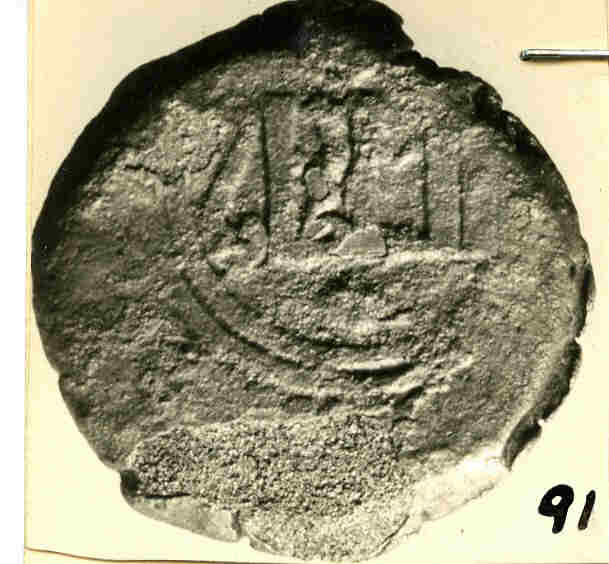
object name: coin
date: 1167-1233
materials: copper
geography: iran